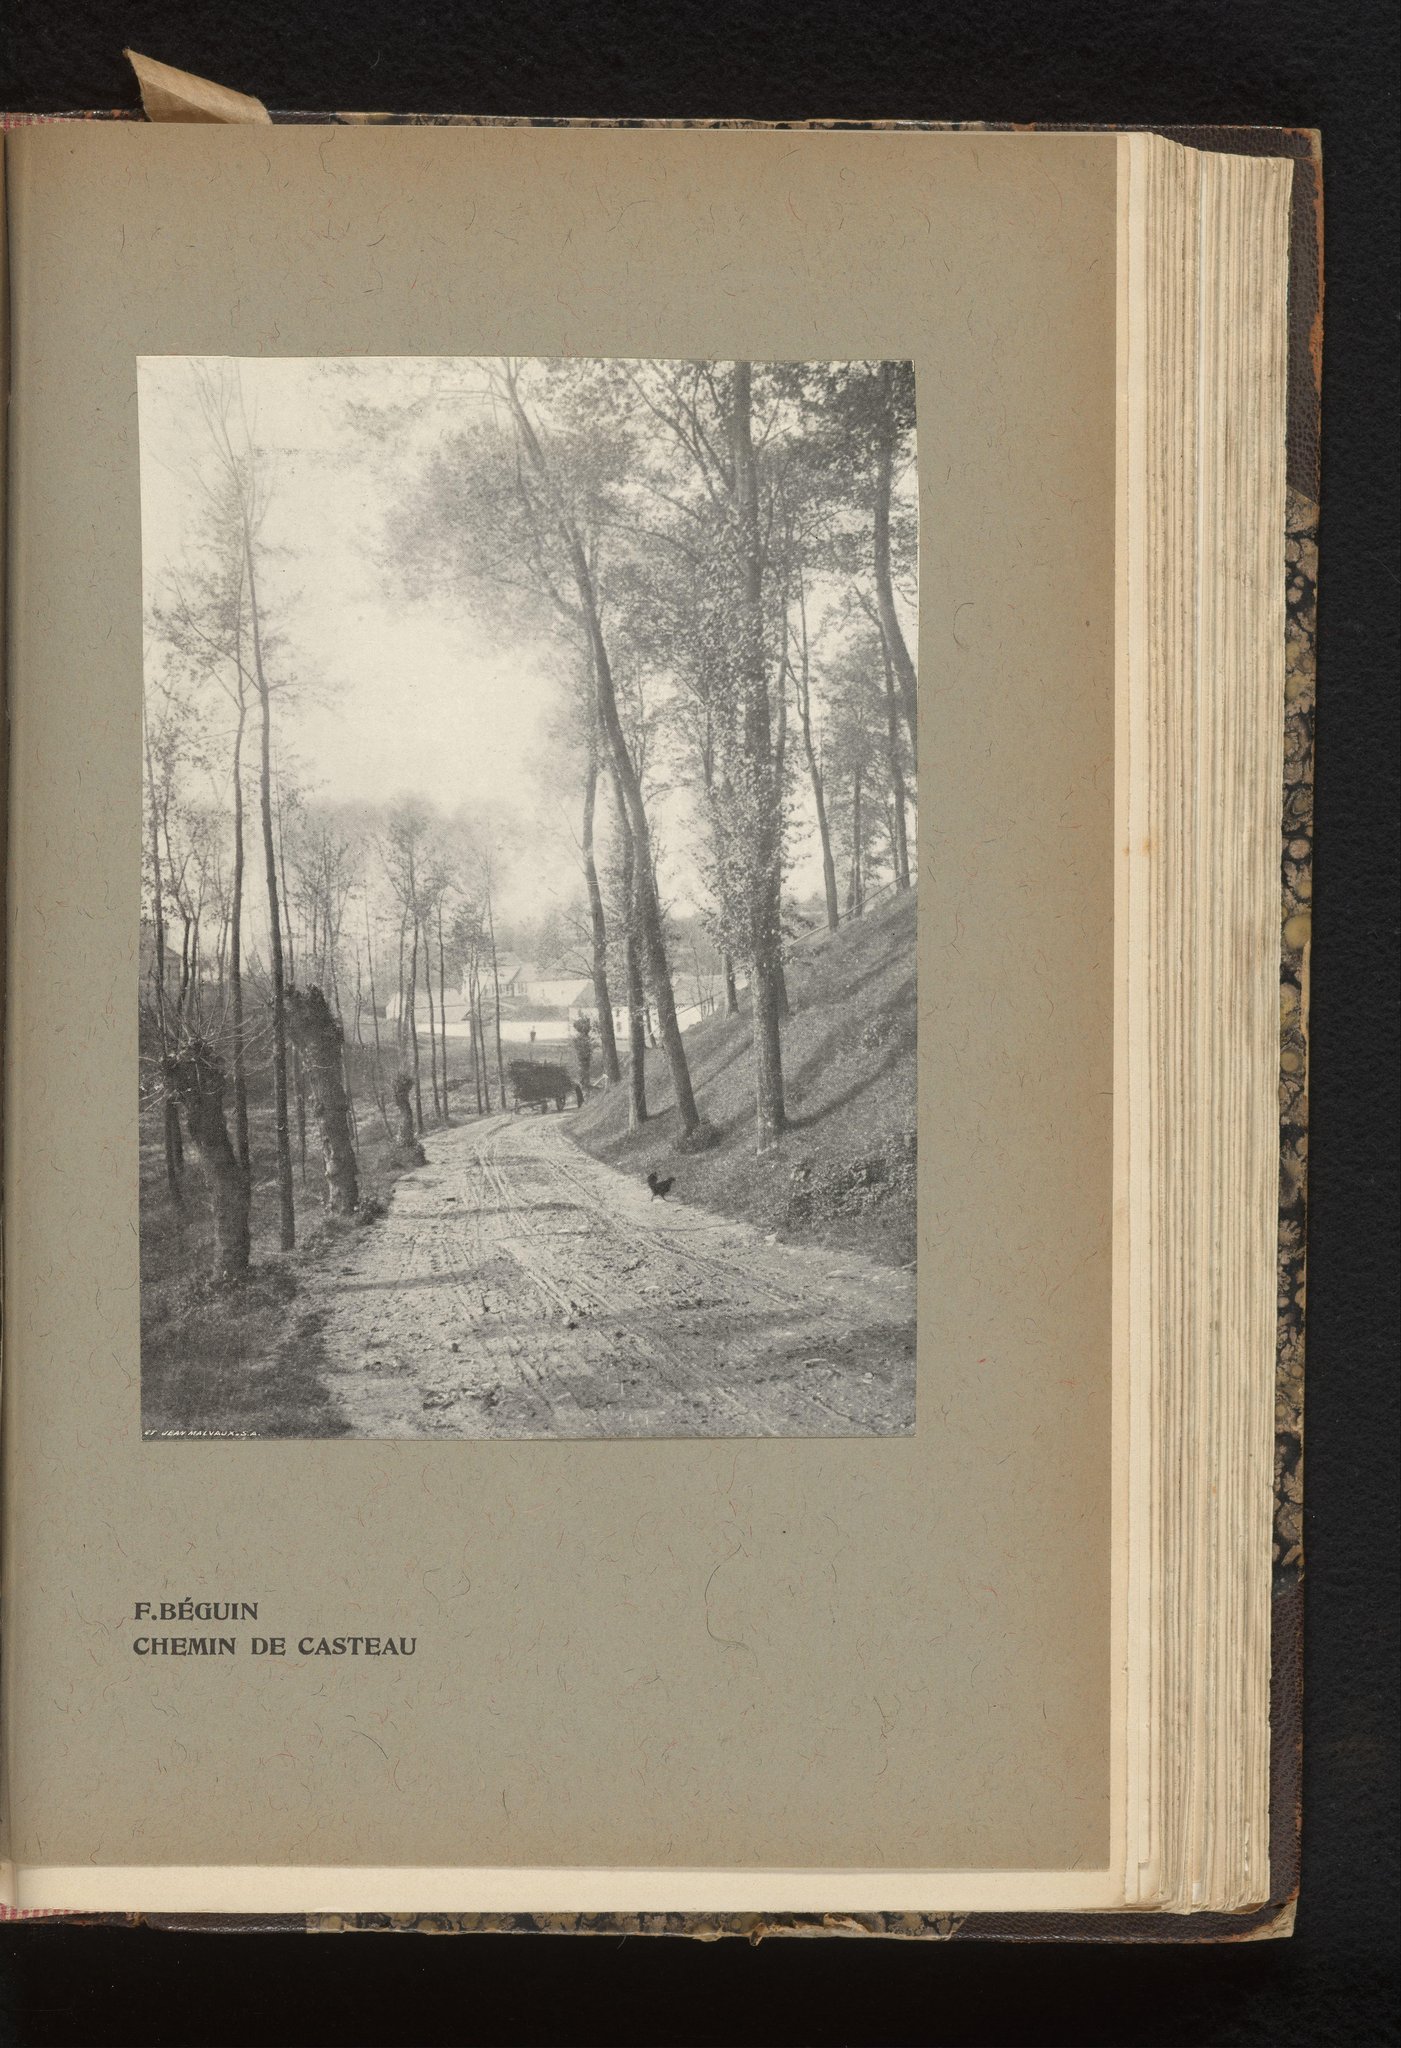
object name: page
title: Kar op een bospad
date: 1897-1902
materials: paper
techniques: autotype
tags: forest path or lane